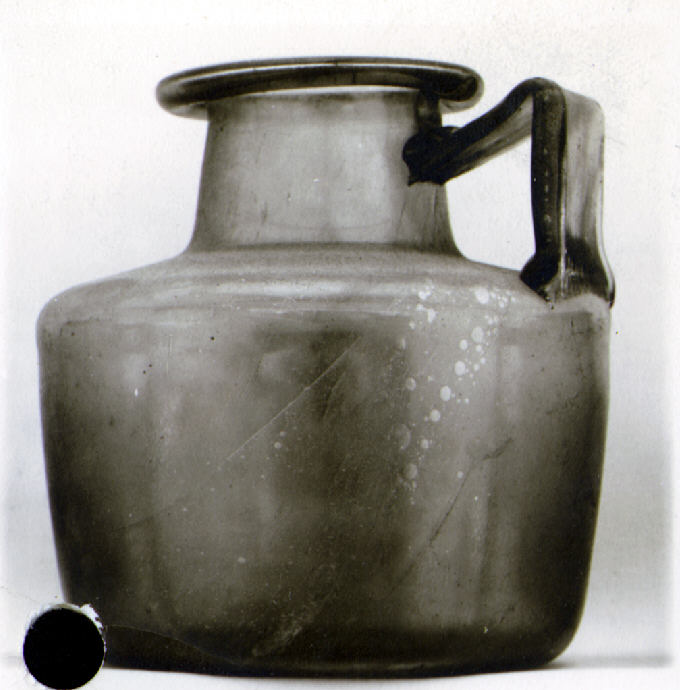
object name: jug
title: Glass one-handled jug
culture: roman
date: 1-200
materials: glass